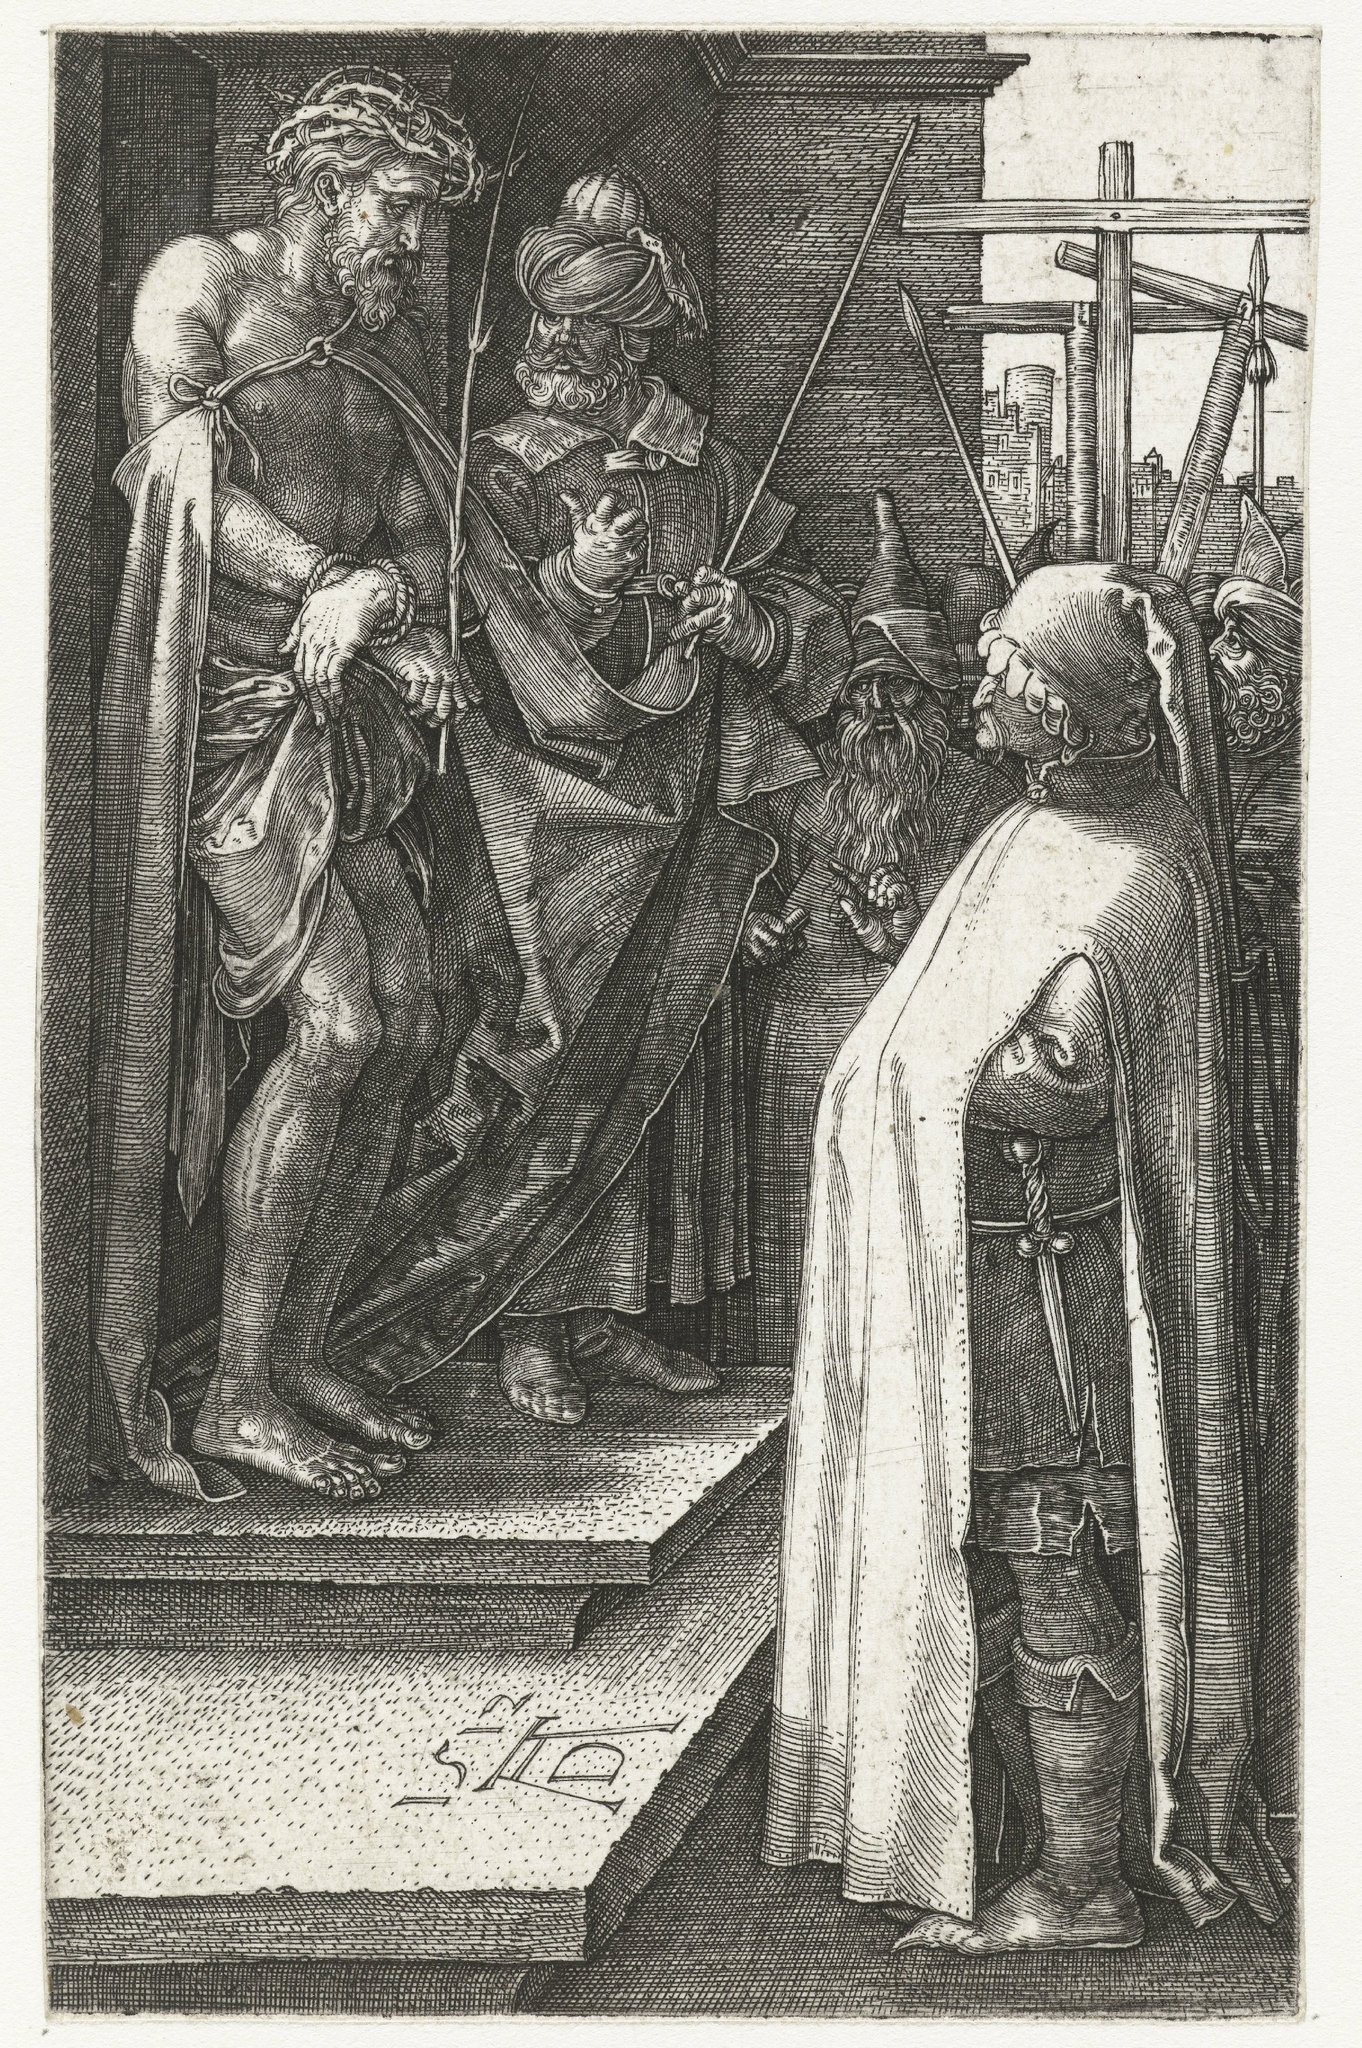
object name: print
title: Christus aan het volk getoond (Ecce homo)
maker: albrecht dürer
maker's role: draughtsman, painter, print maker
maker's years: 1471-1528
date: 1512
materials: paper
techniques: engraving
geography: nuremberg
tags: pilate showing christ to the people, 'ostentatio christi', 'ecce homo' (john 19:4-6)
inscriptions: collector's mark: Lugt 2228a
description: Christus wordt door Pilatus op een podium aan een groep mensen gepresenteerd. Deze prent is onderdeel van een serie van 16 prenten met scènes uit het Lijdensverhaal.